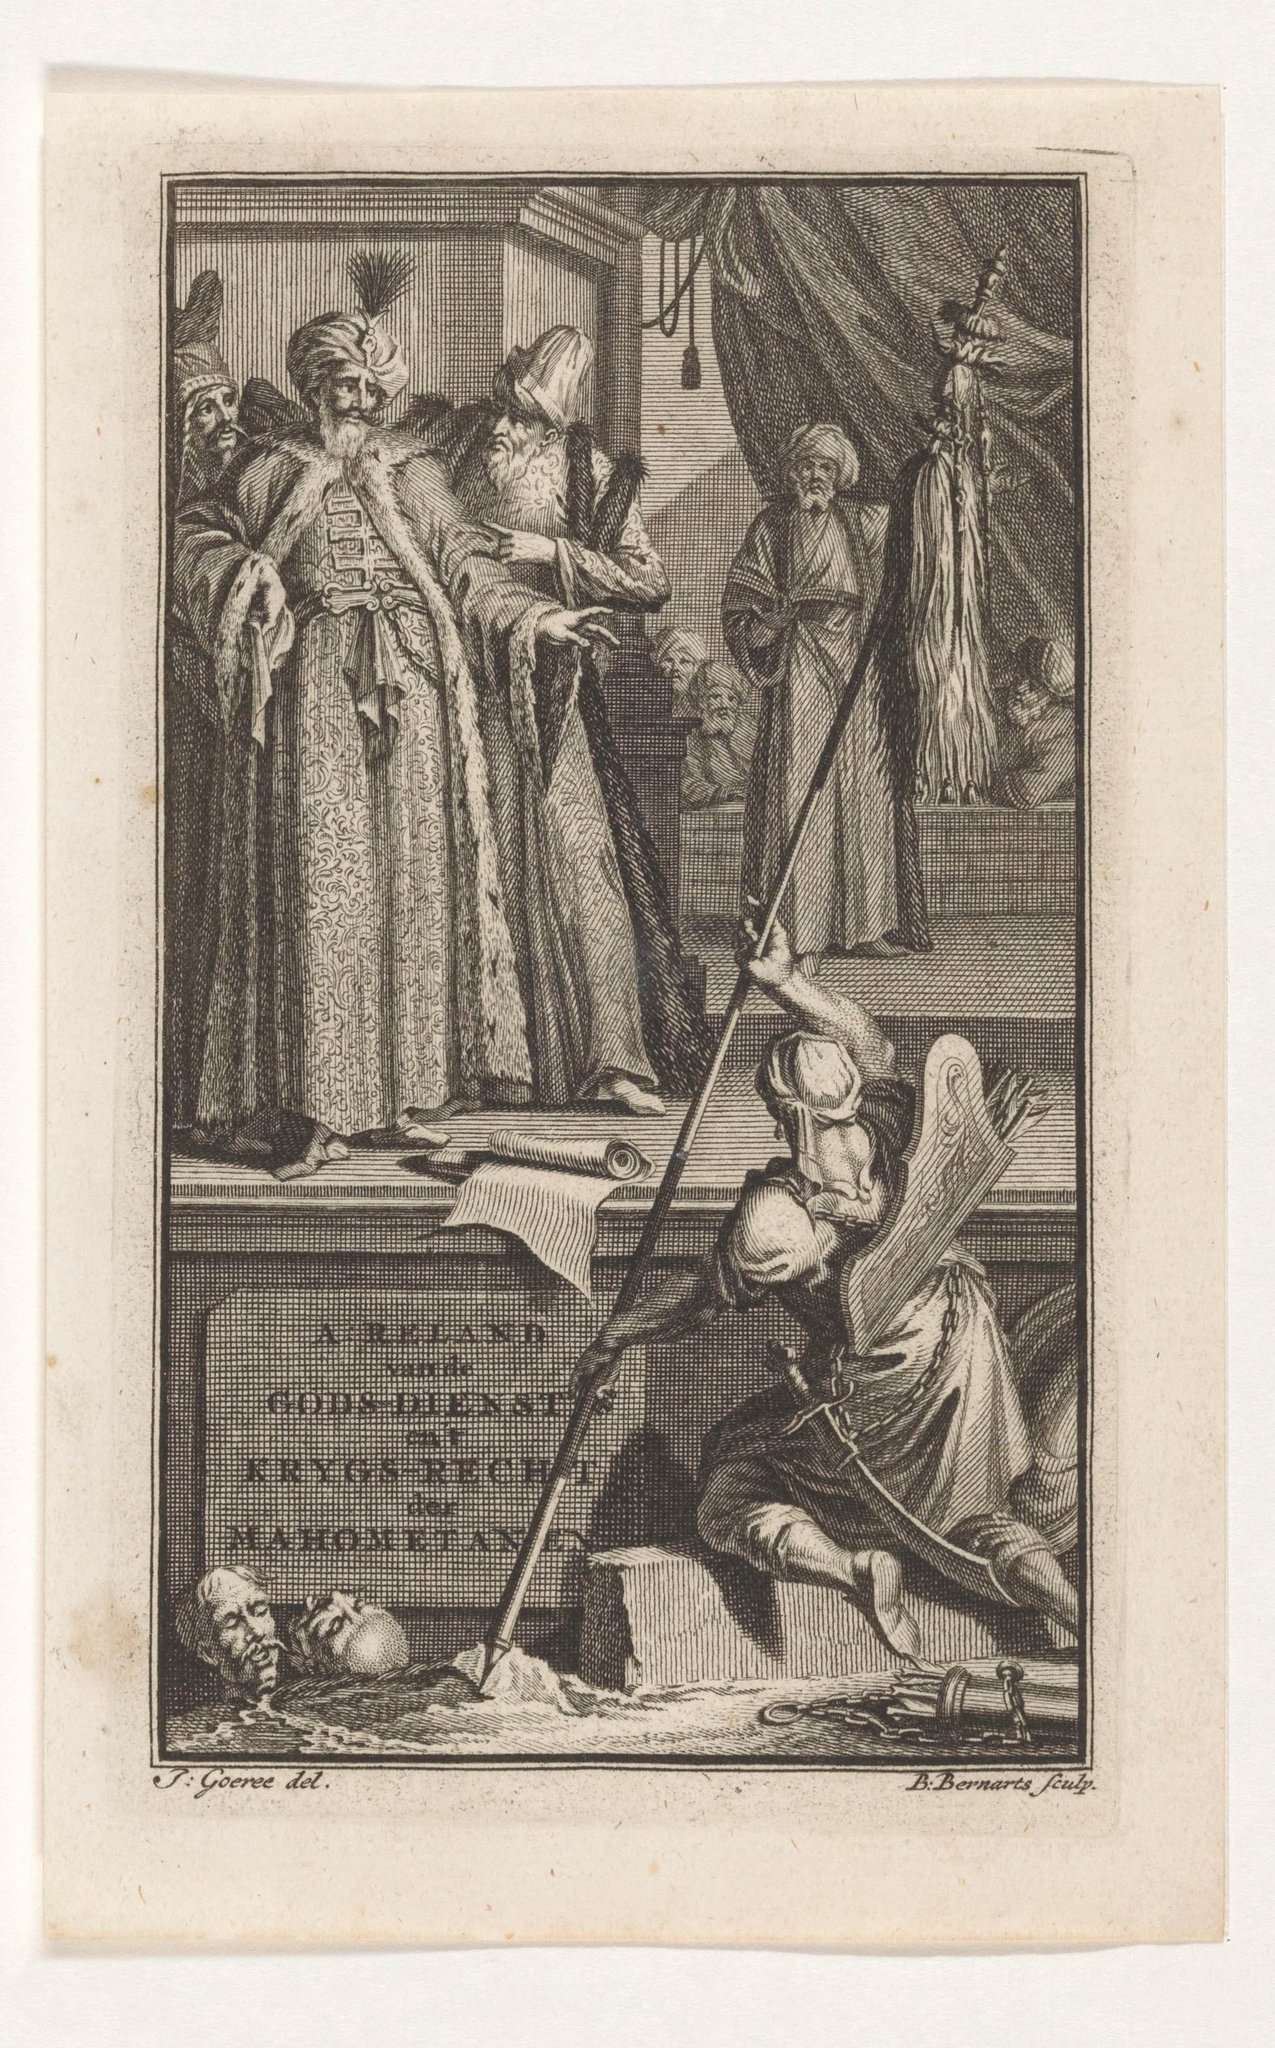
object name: titelblad, titelpagina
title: Islamitische mannen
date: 1718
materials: paper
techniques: engraving, etching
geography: utrecht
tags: islam, mohammedanism, head-gear: turban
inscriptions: collector's mark: Lugt 2228, collector's mark: Lugt 2760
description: Drie mannen, onder wie één met tulband, staan op een podium. Voor het podium zit een geknielde man met tulband, pijlenkoker en staf, op de rug gezien. Links liggen twee hoofden.